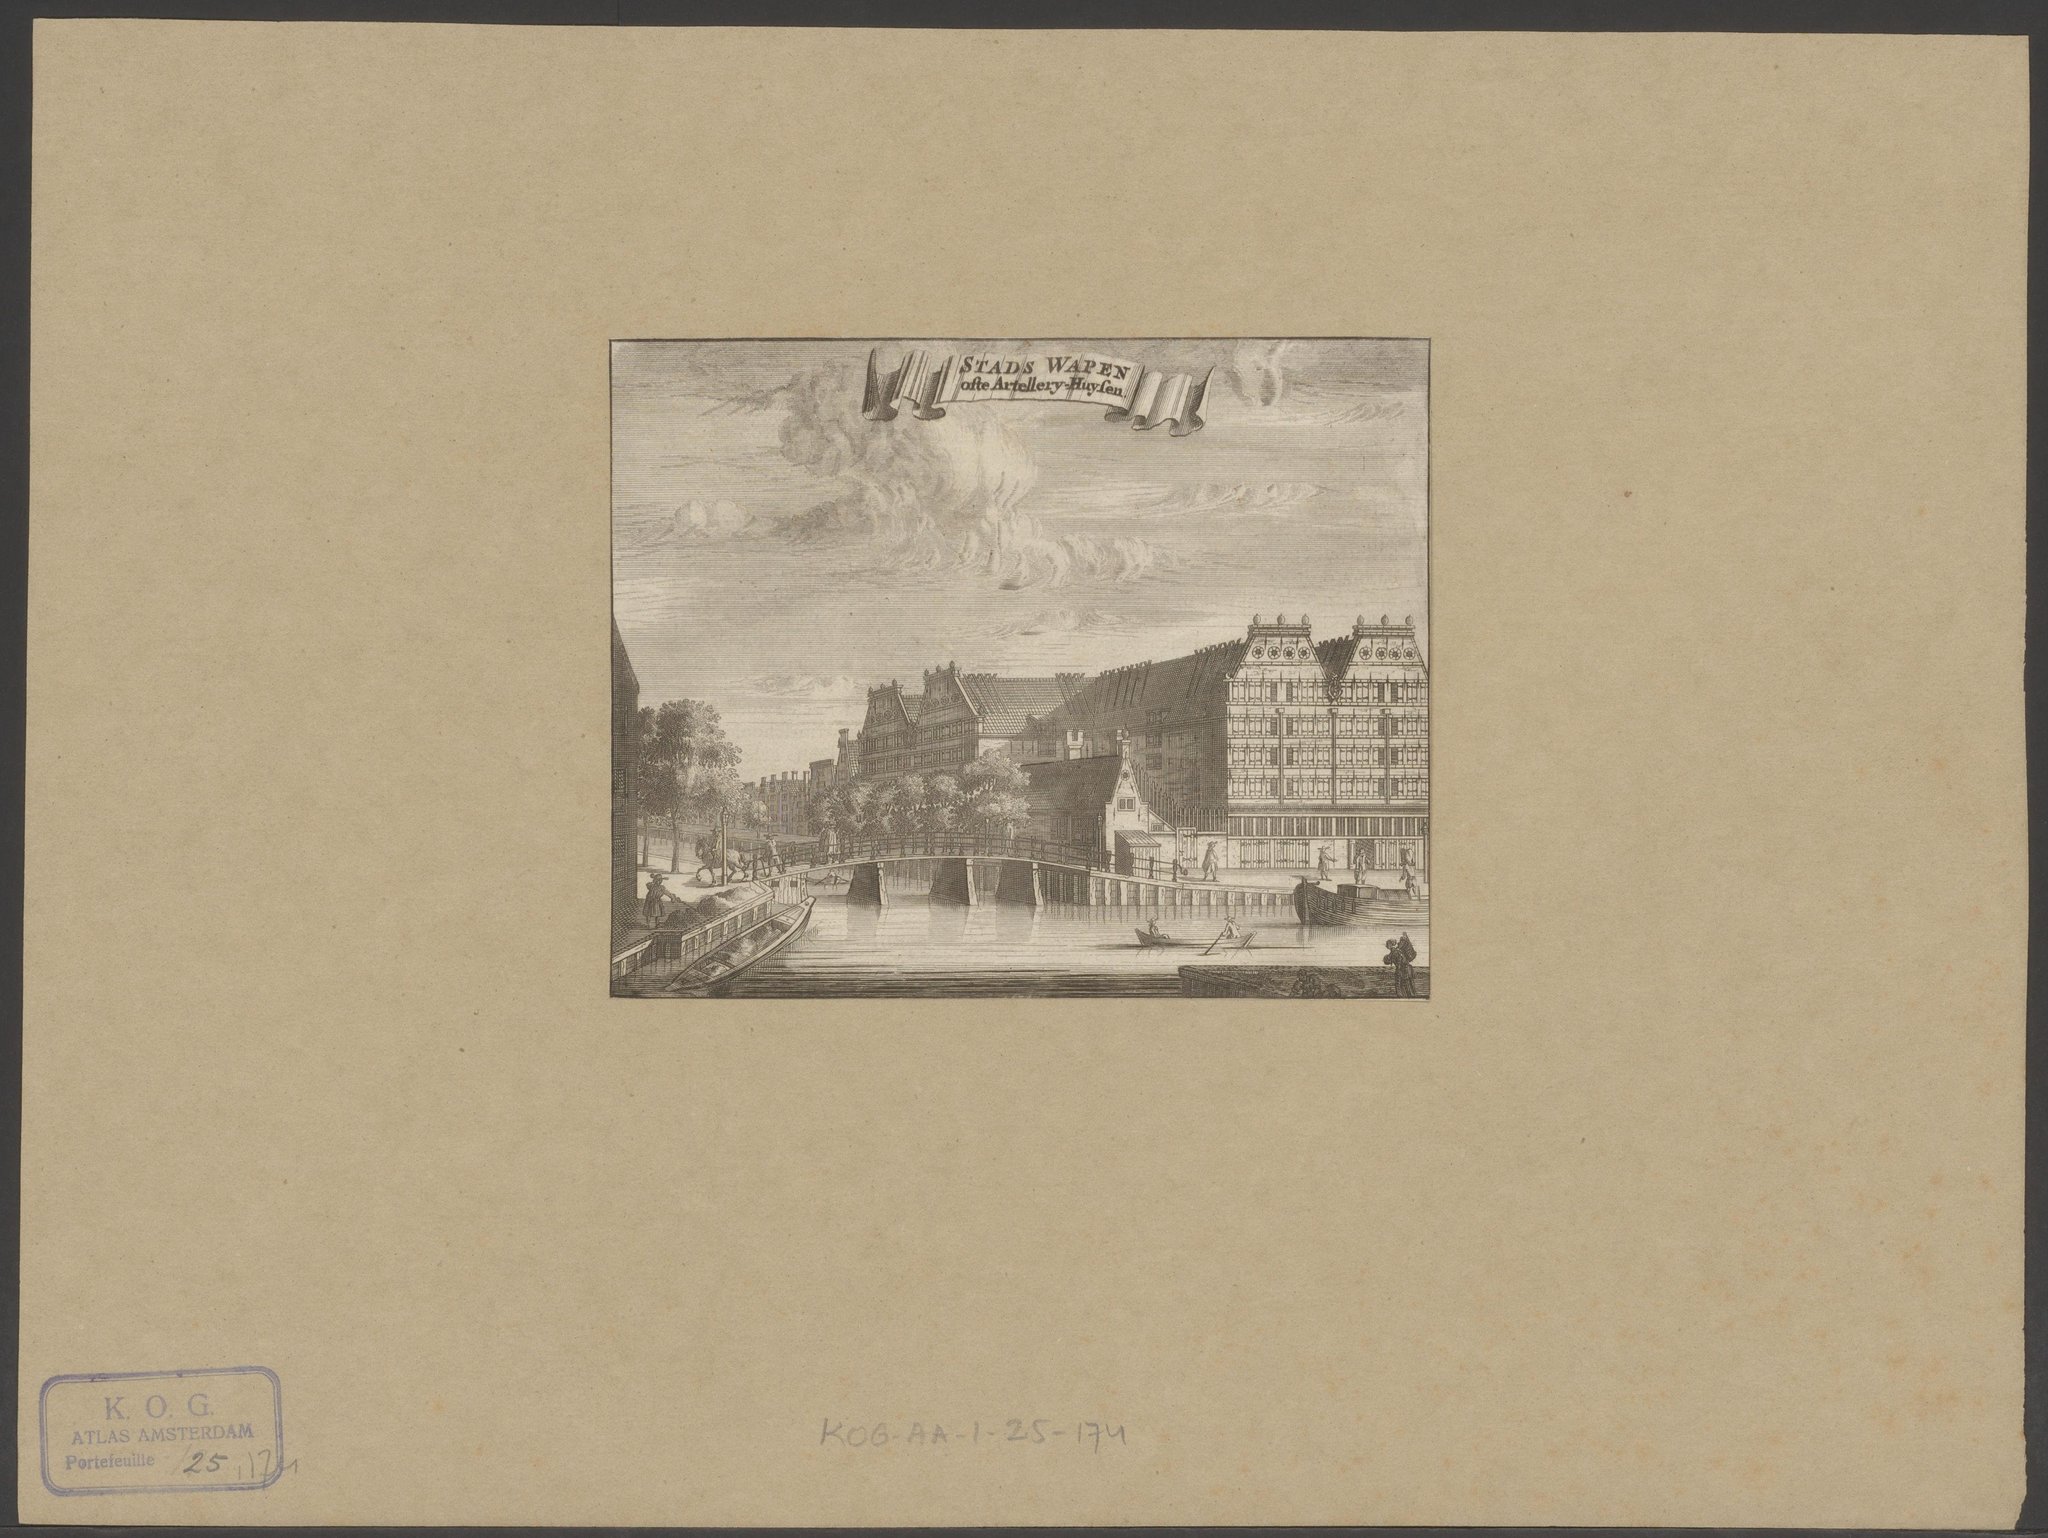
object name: print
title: Stads Wapen ofte Artellery-Huysen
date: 1693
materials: paper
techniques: engraving, etching, letterpress printing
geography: amsterdam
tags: warehouse (~ harbour), large-scale structure for storage, e.g.: warehouse, depot, silo, bridge in city across river, canal, etc. (+ city(-scape) with figures, staffage), canals, waters (in city) (+ city(-scape) with figures, staffage), ammunition store, arsenal, street (+ city(-scape) with figures, staffage)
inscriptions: collector's mark: ‘25.174’ Lugt 1641b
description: Huidige staat van prent gebruikt in: Commelin, Caspar. Beschryvinge van Amsterdam, desselfs eerste oorspronk uyt den Huyse (…). 2 dln. Amsterdam: Abraham Wolfgang, Gillis Janssonius van Waesberge, Johannes Janssonius van Waesberge II, weduwe Dirk Boom I, Hendrick Boom en Rembertus Goethals, 1693. En in: Commelin, Caspar. Beschryvinge van Amsterdam, zynde een naukeurige verhandelinge van desselfs eerste oorspronk uyt (…). 2 dln. Amsterdam: weduwe Aart Dircksz Oossaan, 1694. Latere staat van prent ook gebruikt in: Commelin, Caspar. Beschryvinge van Amsterdam, zynde een naukeurige verhandelinge van desselfs eerste oorspronk uyt (…). 2 dln. 2de druk. Amsterdam: Andries van Damme, Johannes Ratelband, weduwe A. van Aaltwyk en Hermanus Uytwerf, 1726.